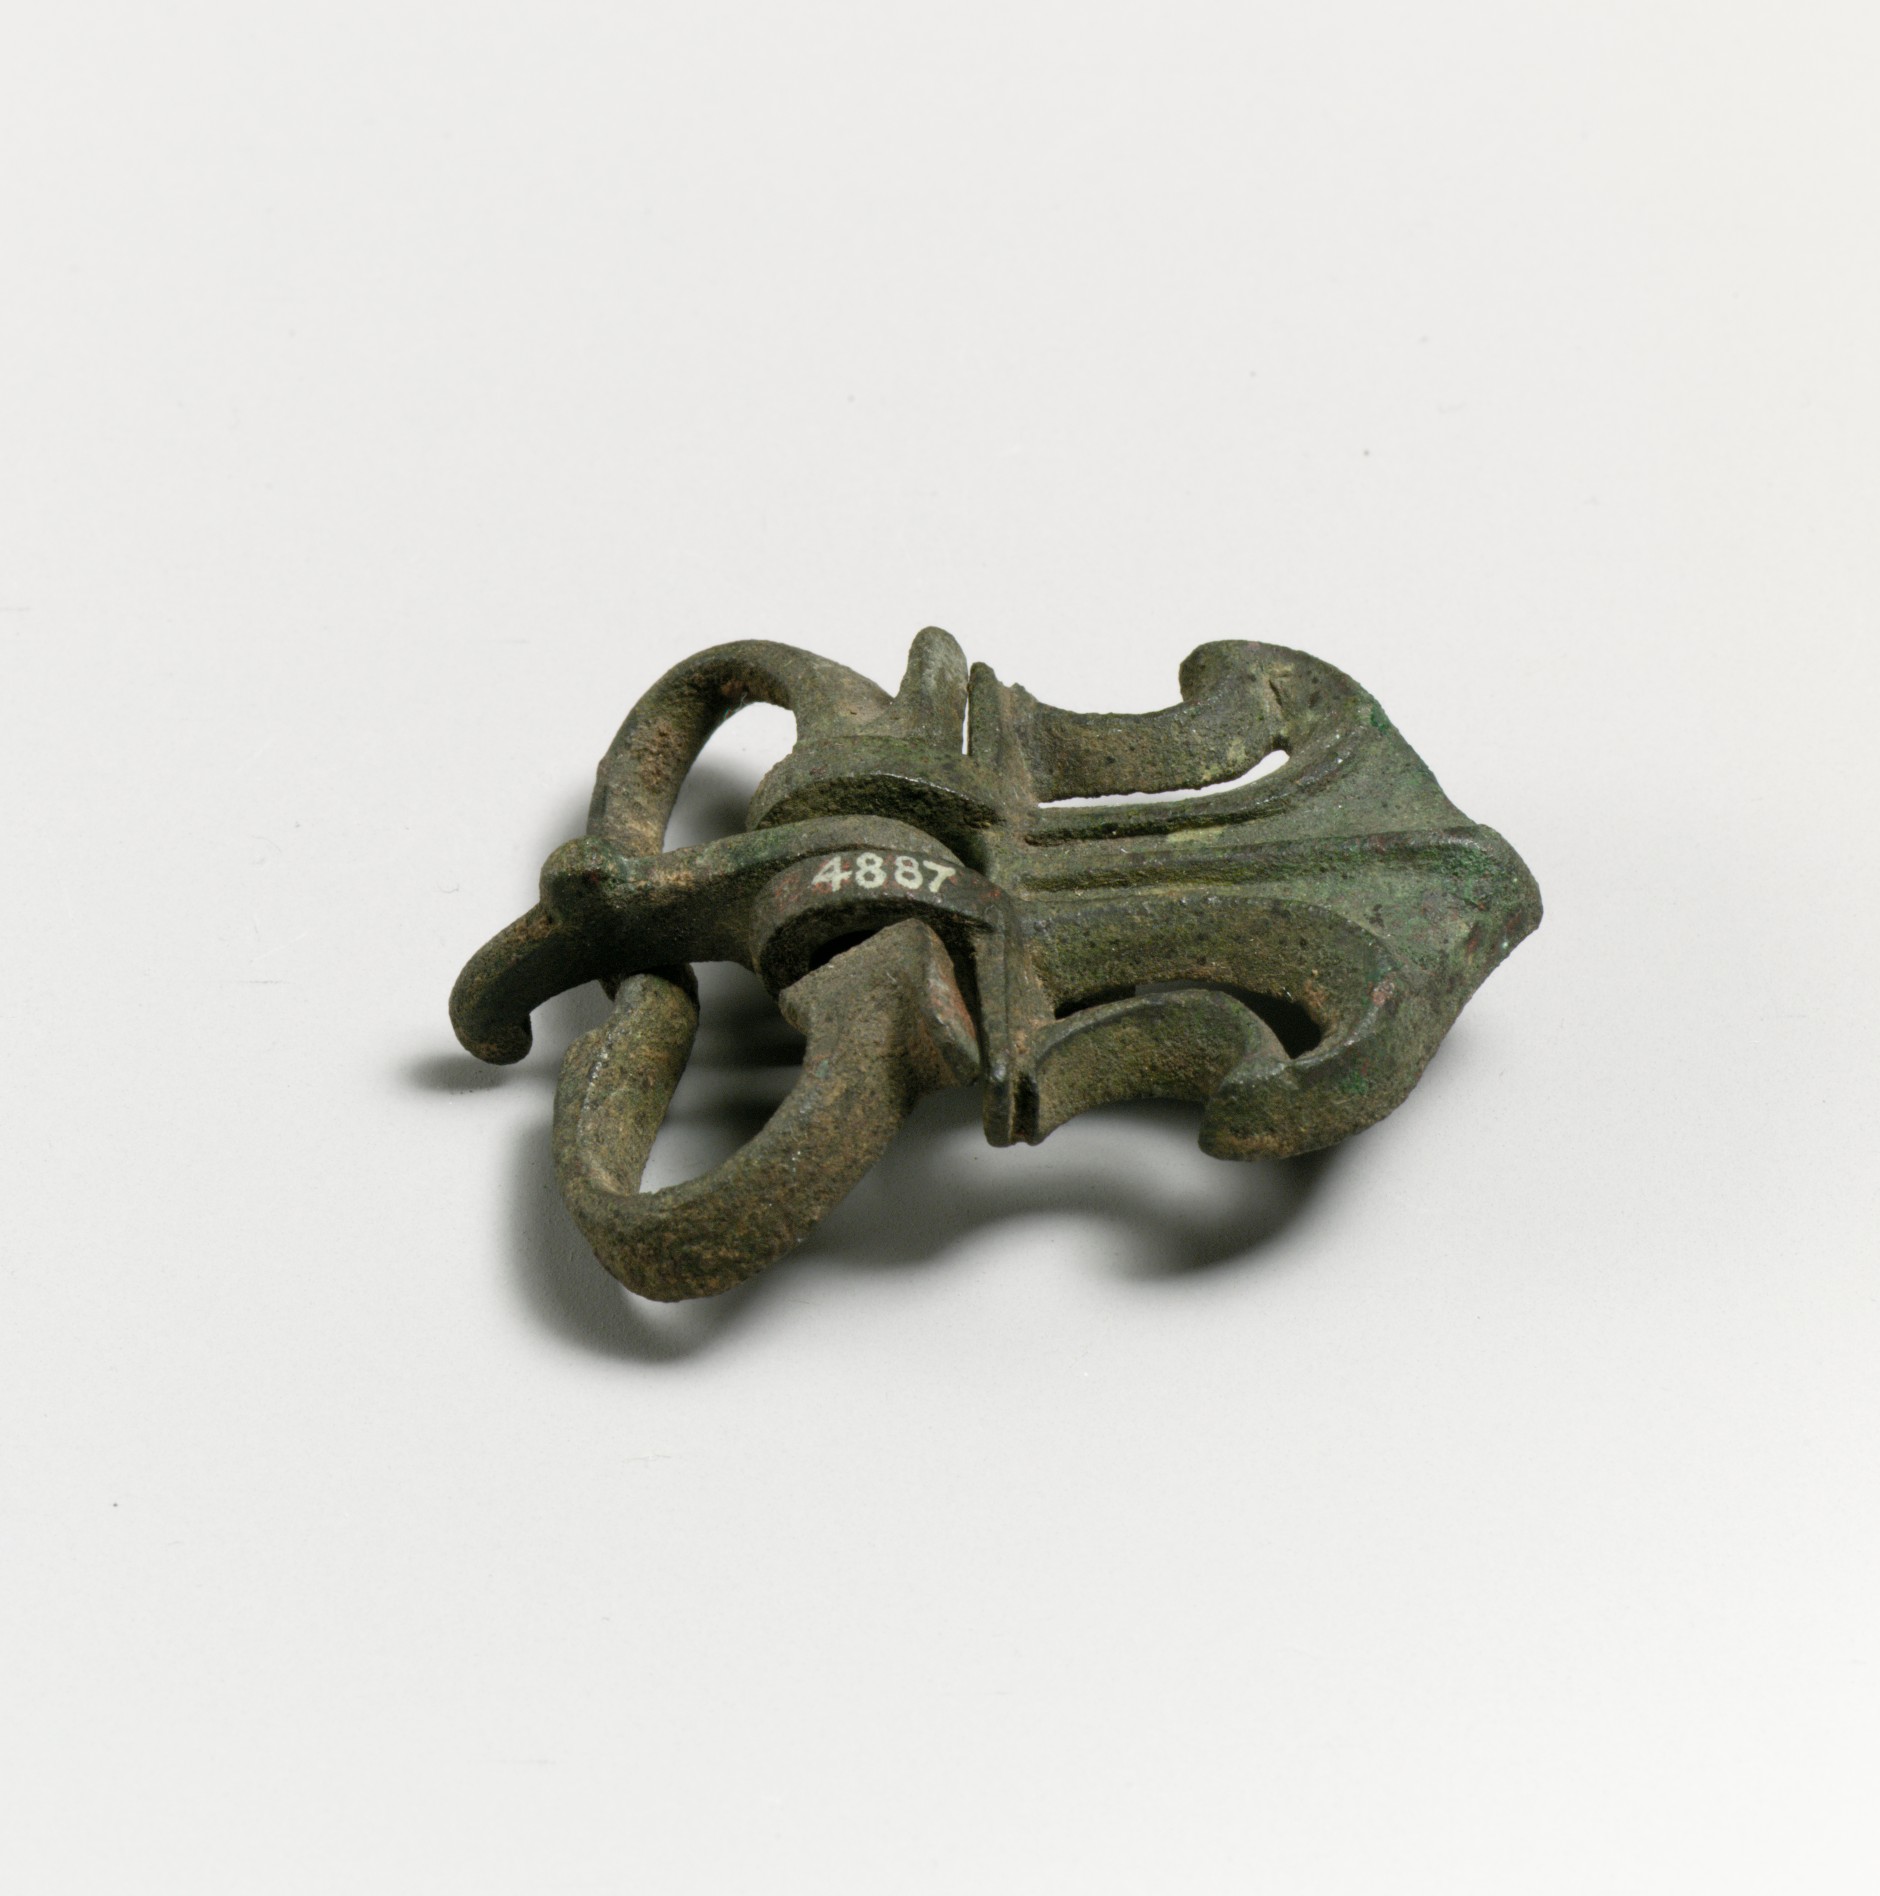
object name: buckle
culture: cypriot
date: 3900 BCE-100 CE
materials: bronze